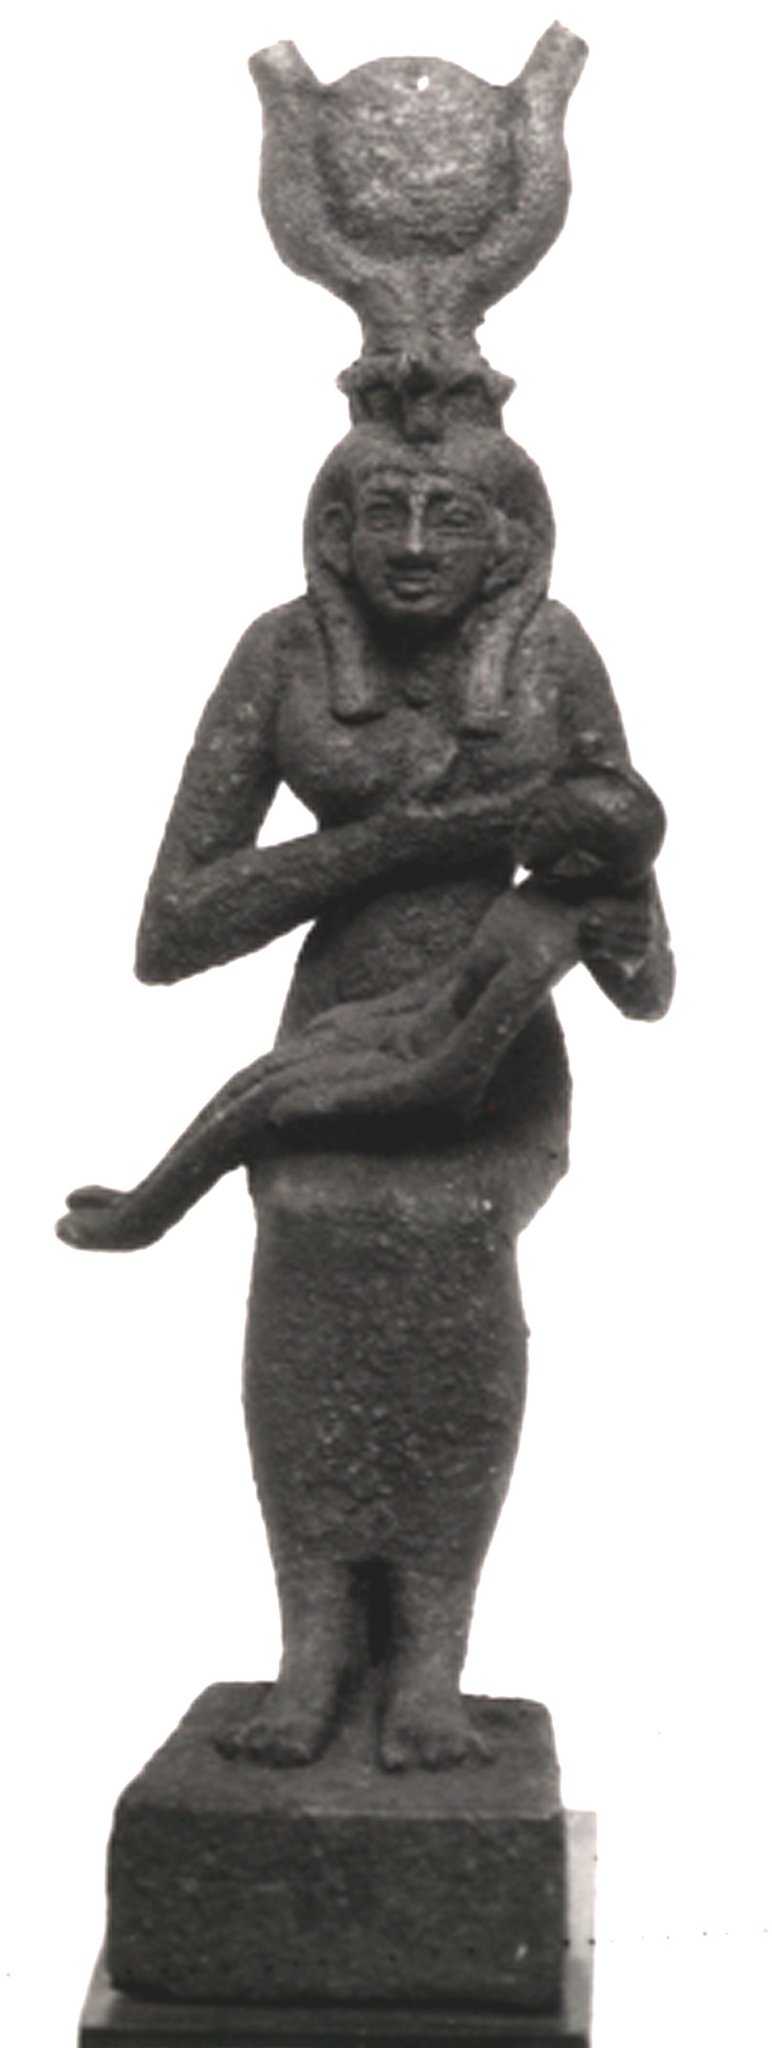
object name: statuette, isi, horus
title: Statuette of Isis and Horus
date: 664-332 BCE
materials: copper alloy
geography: egypt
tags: horus,isis,nursing